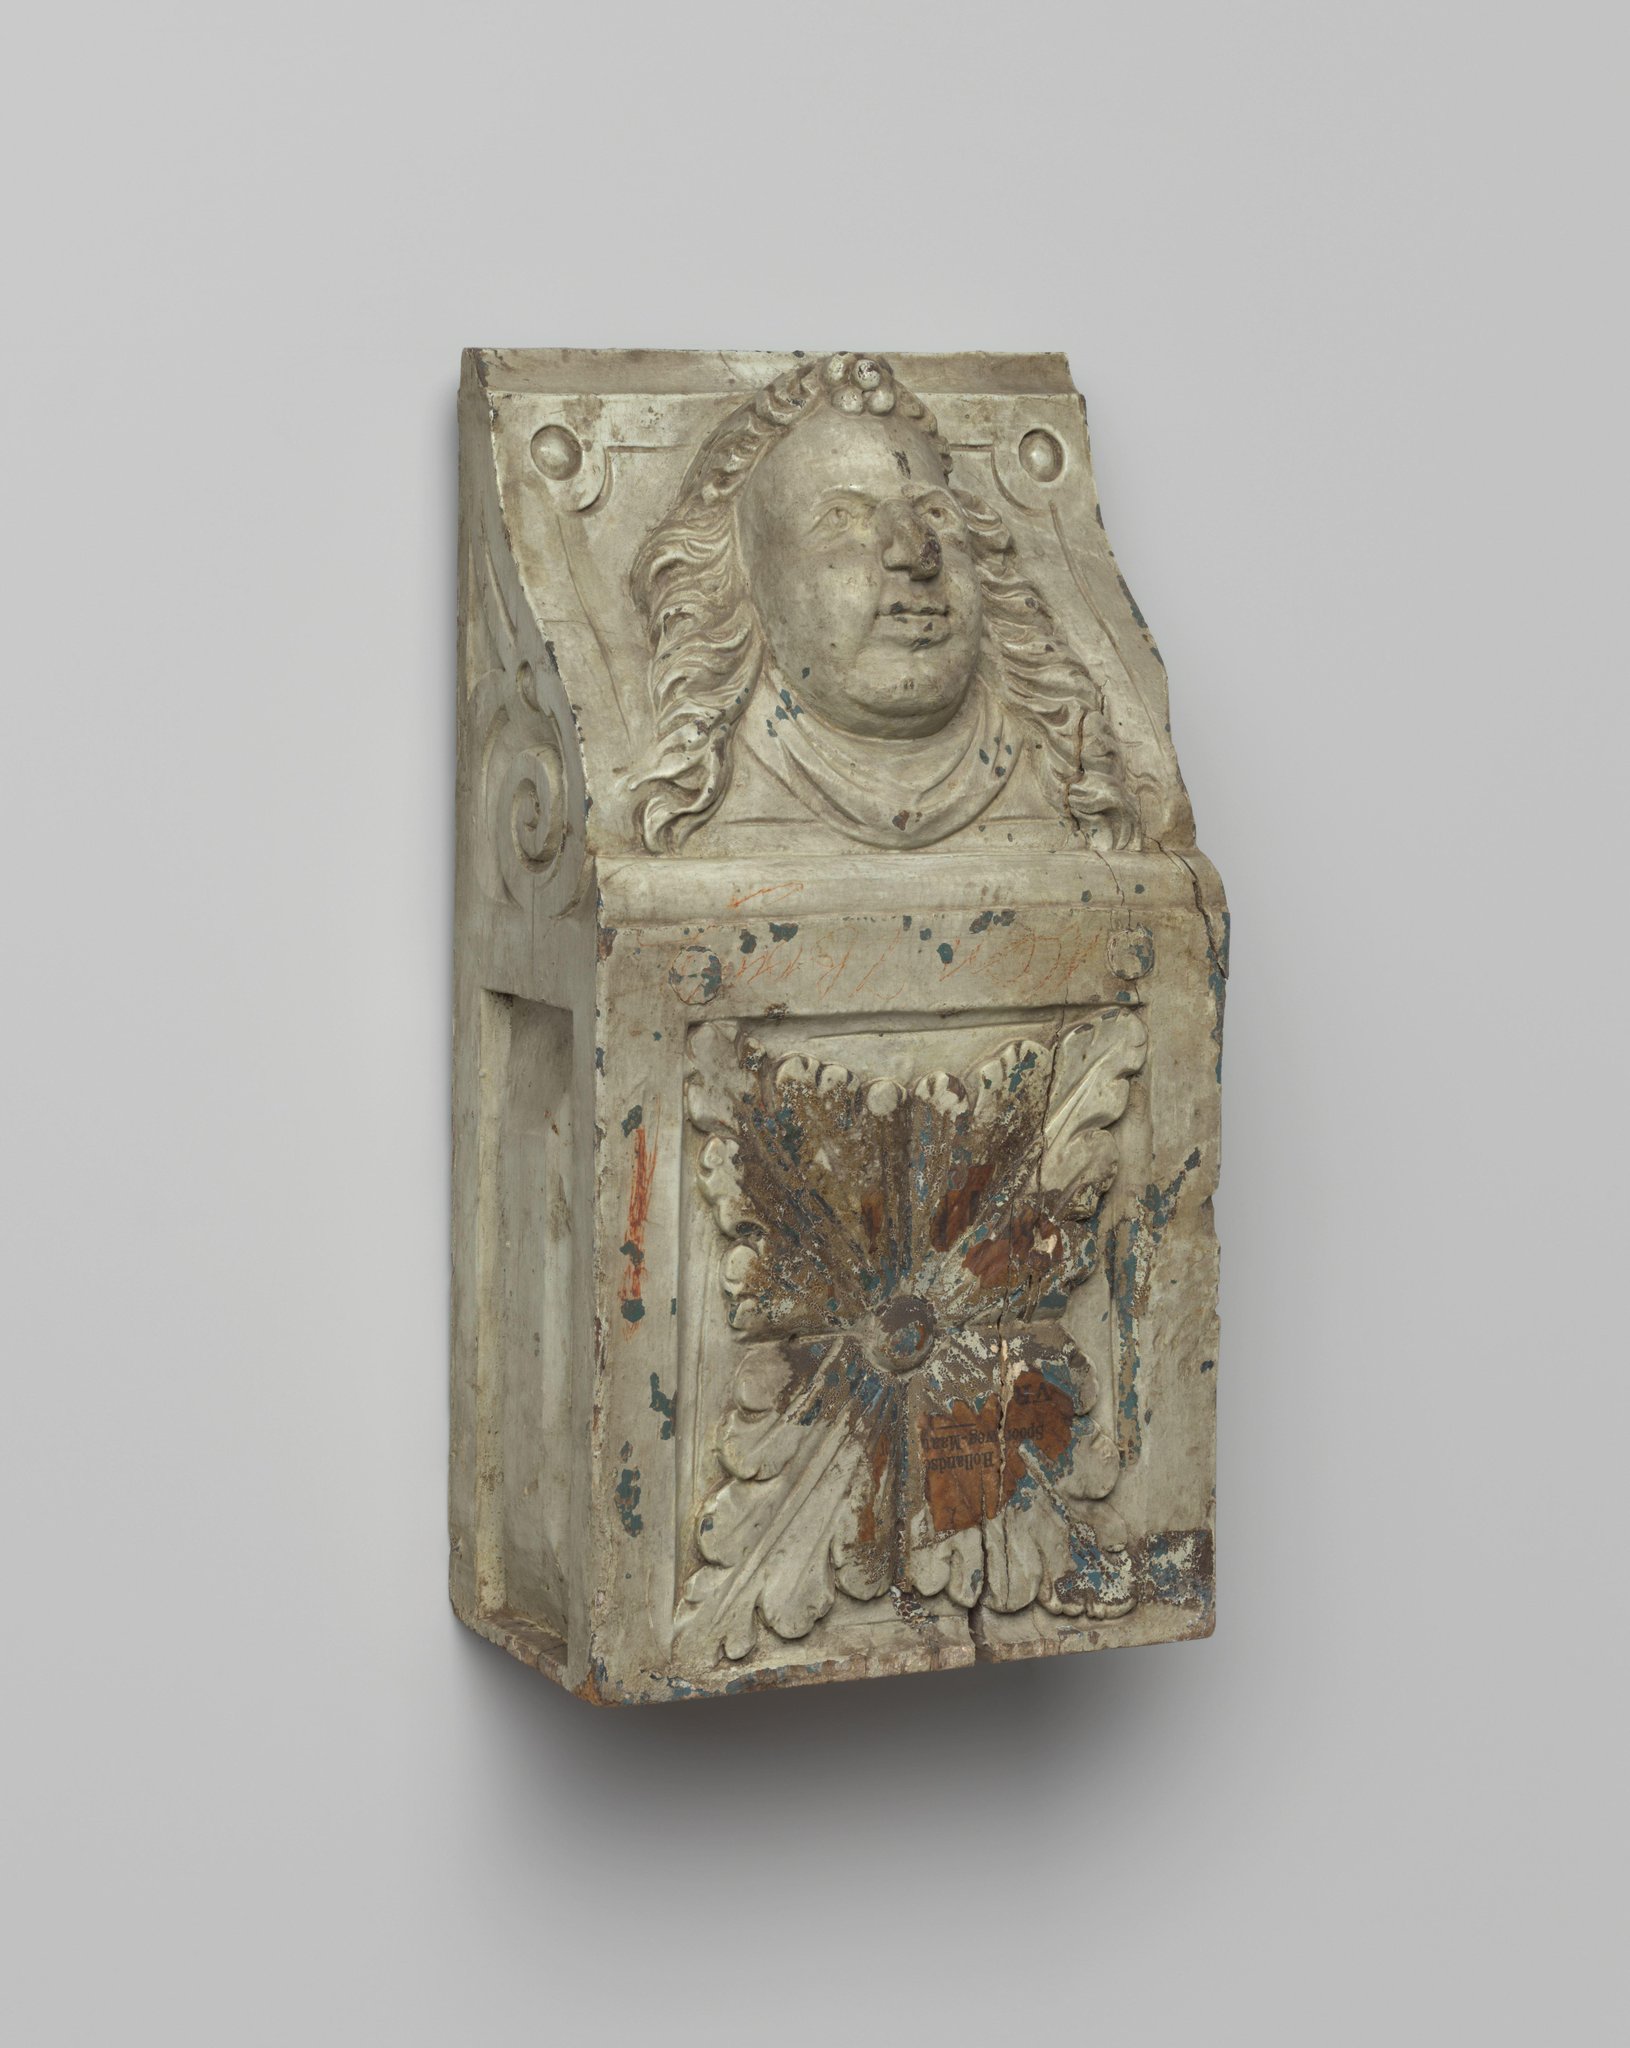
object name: high relief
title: Balksleutel van eikenhout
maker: Anonymous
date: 1550-1600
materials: wood, paint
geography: northern netherlands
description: Balksleutel van eikenhout, aan de onderkant versierd met een bladornament, aan de dagkant met een vrouwehoofd en-haut reliëf gesneden. De zijde vertoont wit geschilderd snijwerk.